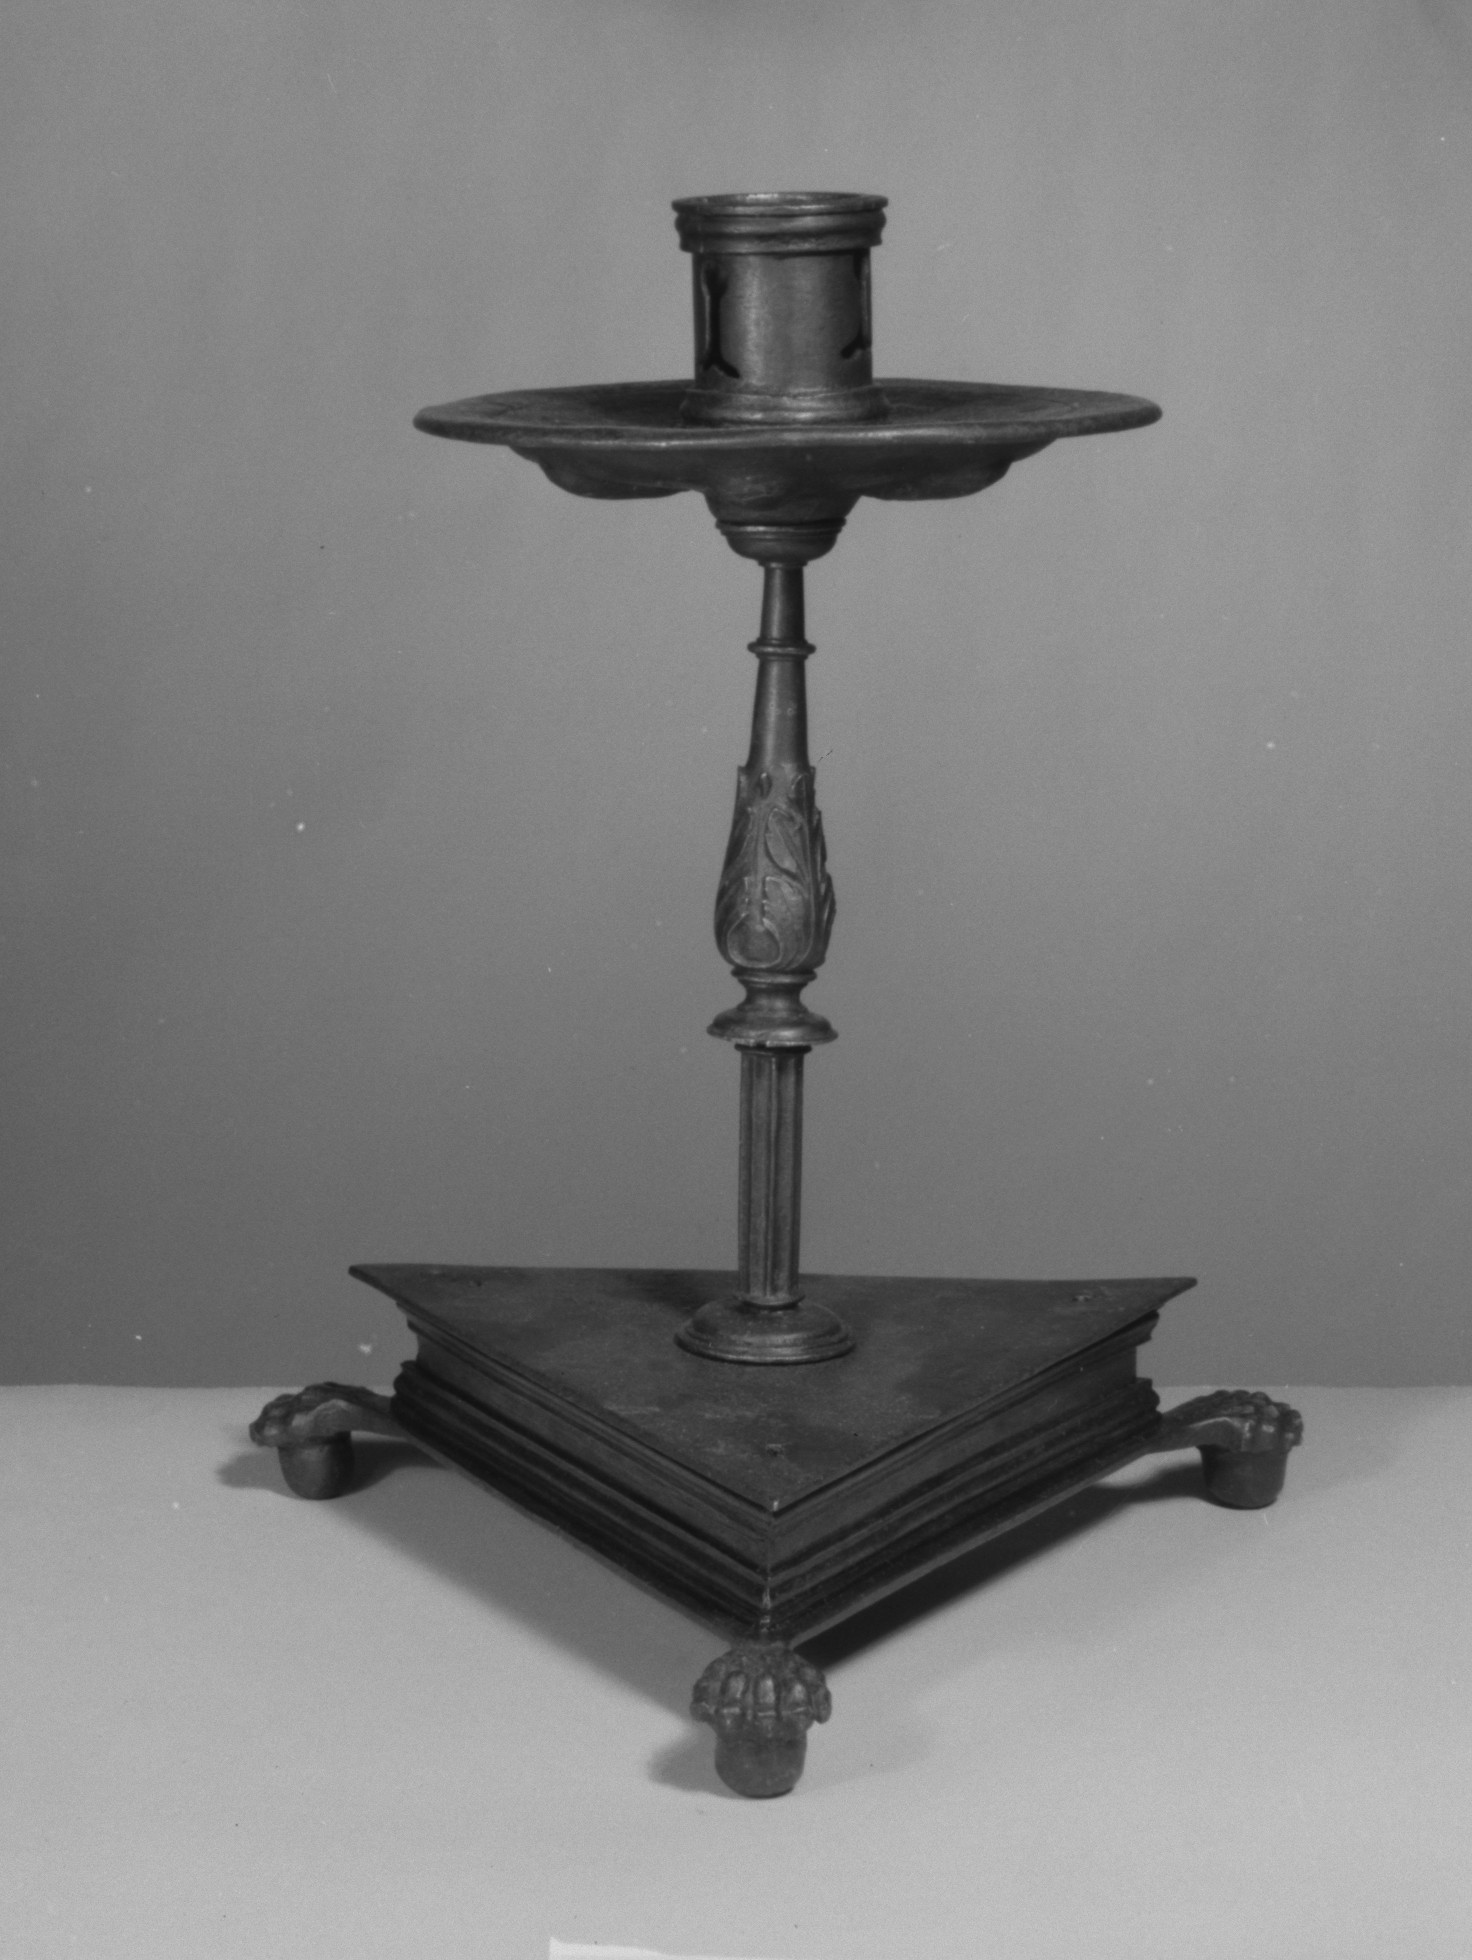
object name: candlestick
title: Pair of candlesticks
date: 1467-1533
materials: iron